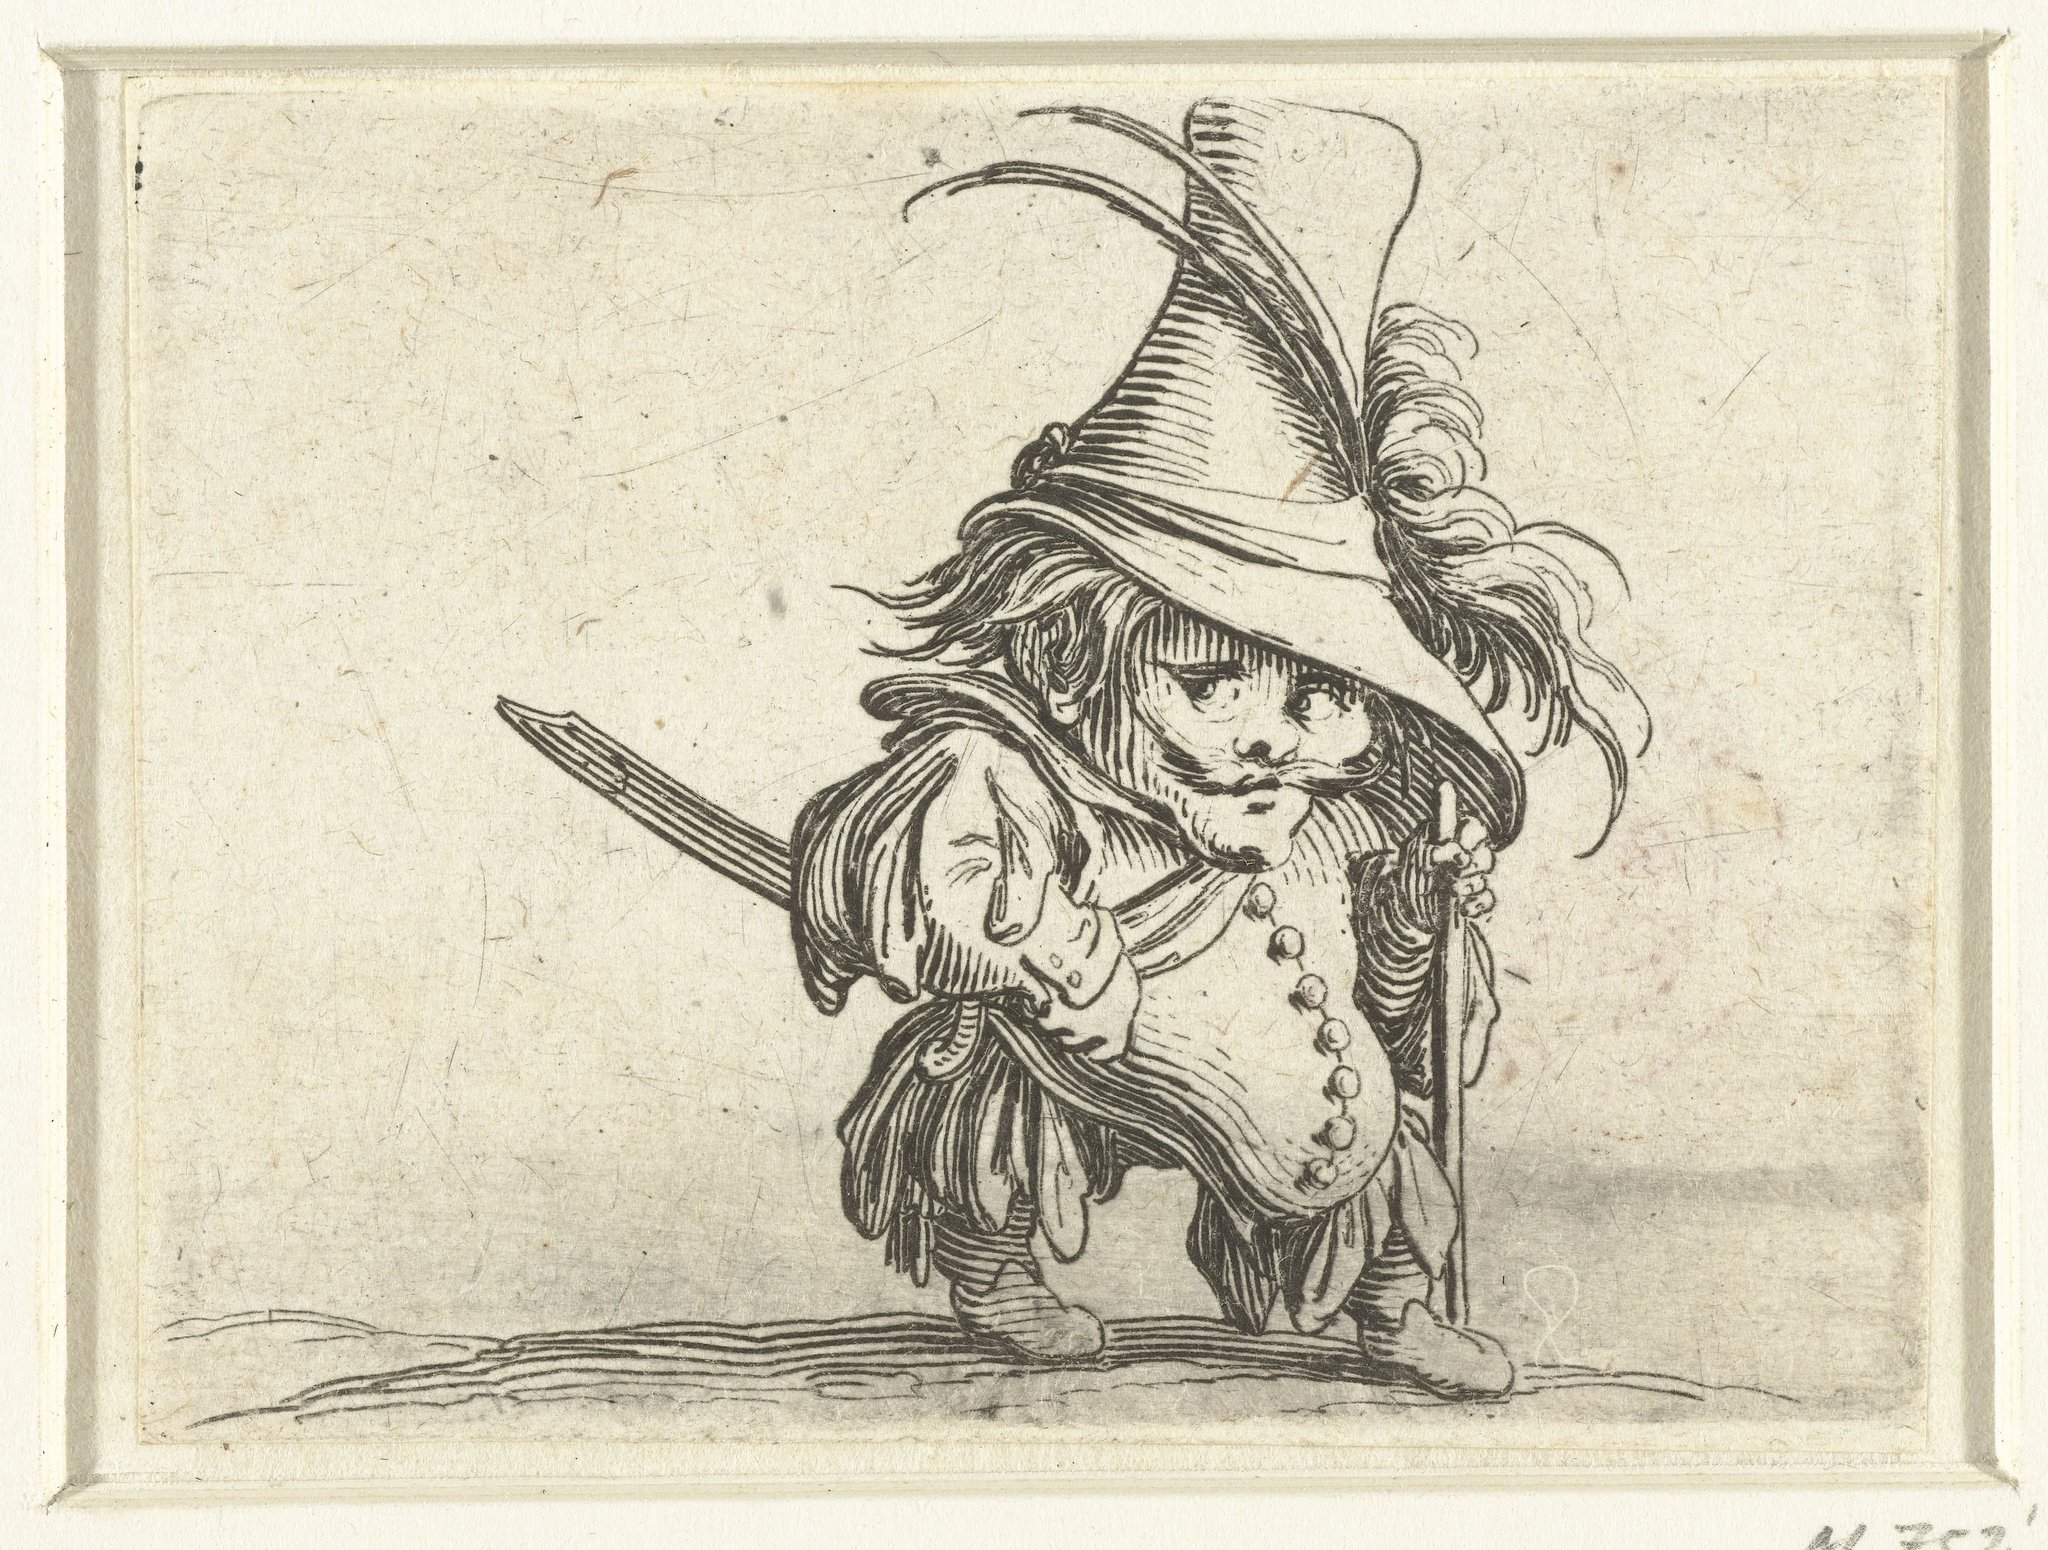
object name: print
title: Kleine mens (karikatuur) met zwaard en wandelstok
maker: jacques callot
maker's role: draughtsman, print maker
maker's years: 1592-1635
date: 1621-1625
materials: paper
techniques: engraving, etching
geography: nancy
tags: little people, walking-stick, staff, hacking and thrusting weapons: sword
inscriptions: collector's mark: Lugt 240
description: Een kleine mens (karikatuur), op de rechterzijde gezien, met een hangende buik waarover een knopenrij loopt, een hoge hoed met veren op het hoofd, de rechterhand aan het gevest van zijn zwaard, een wandelstok in de linkerhand. Deze prent is onderdeel van een serie van 21 prenten met groteske figuren; vrijwel al die figuren zijn karikaturen van kleine mensen, velen zijn gebocheld.